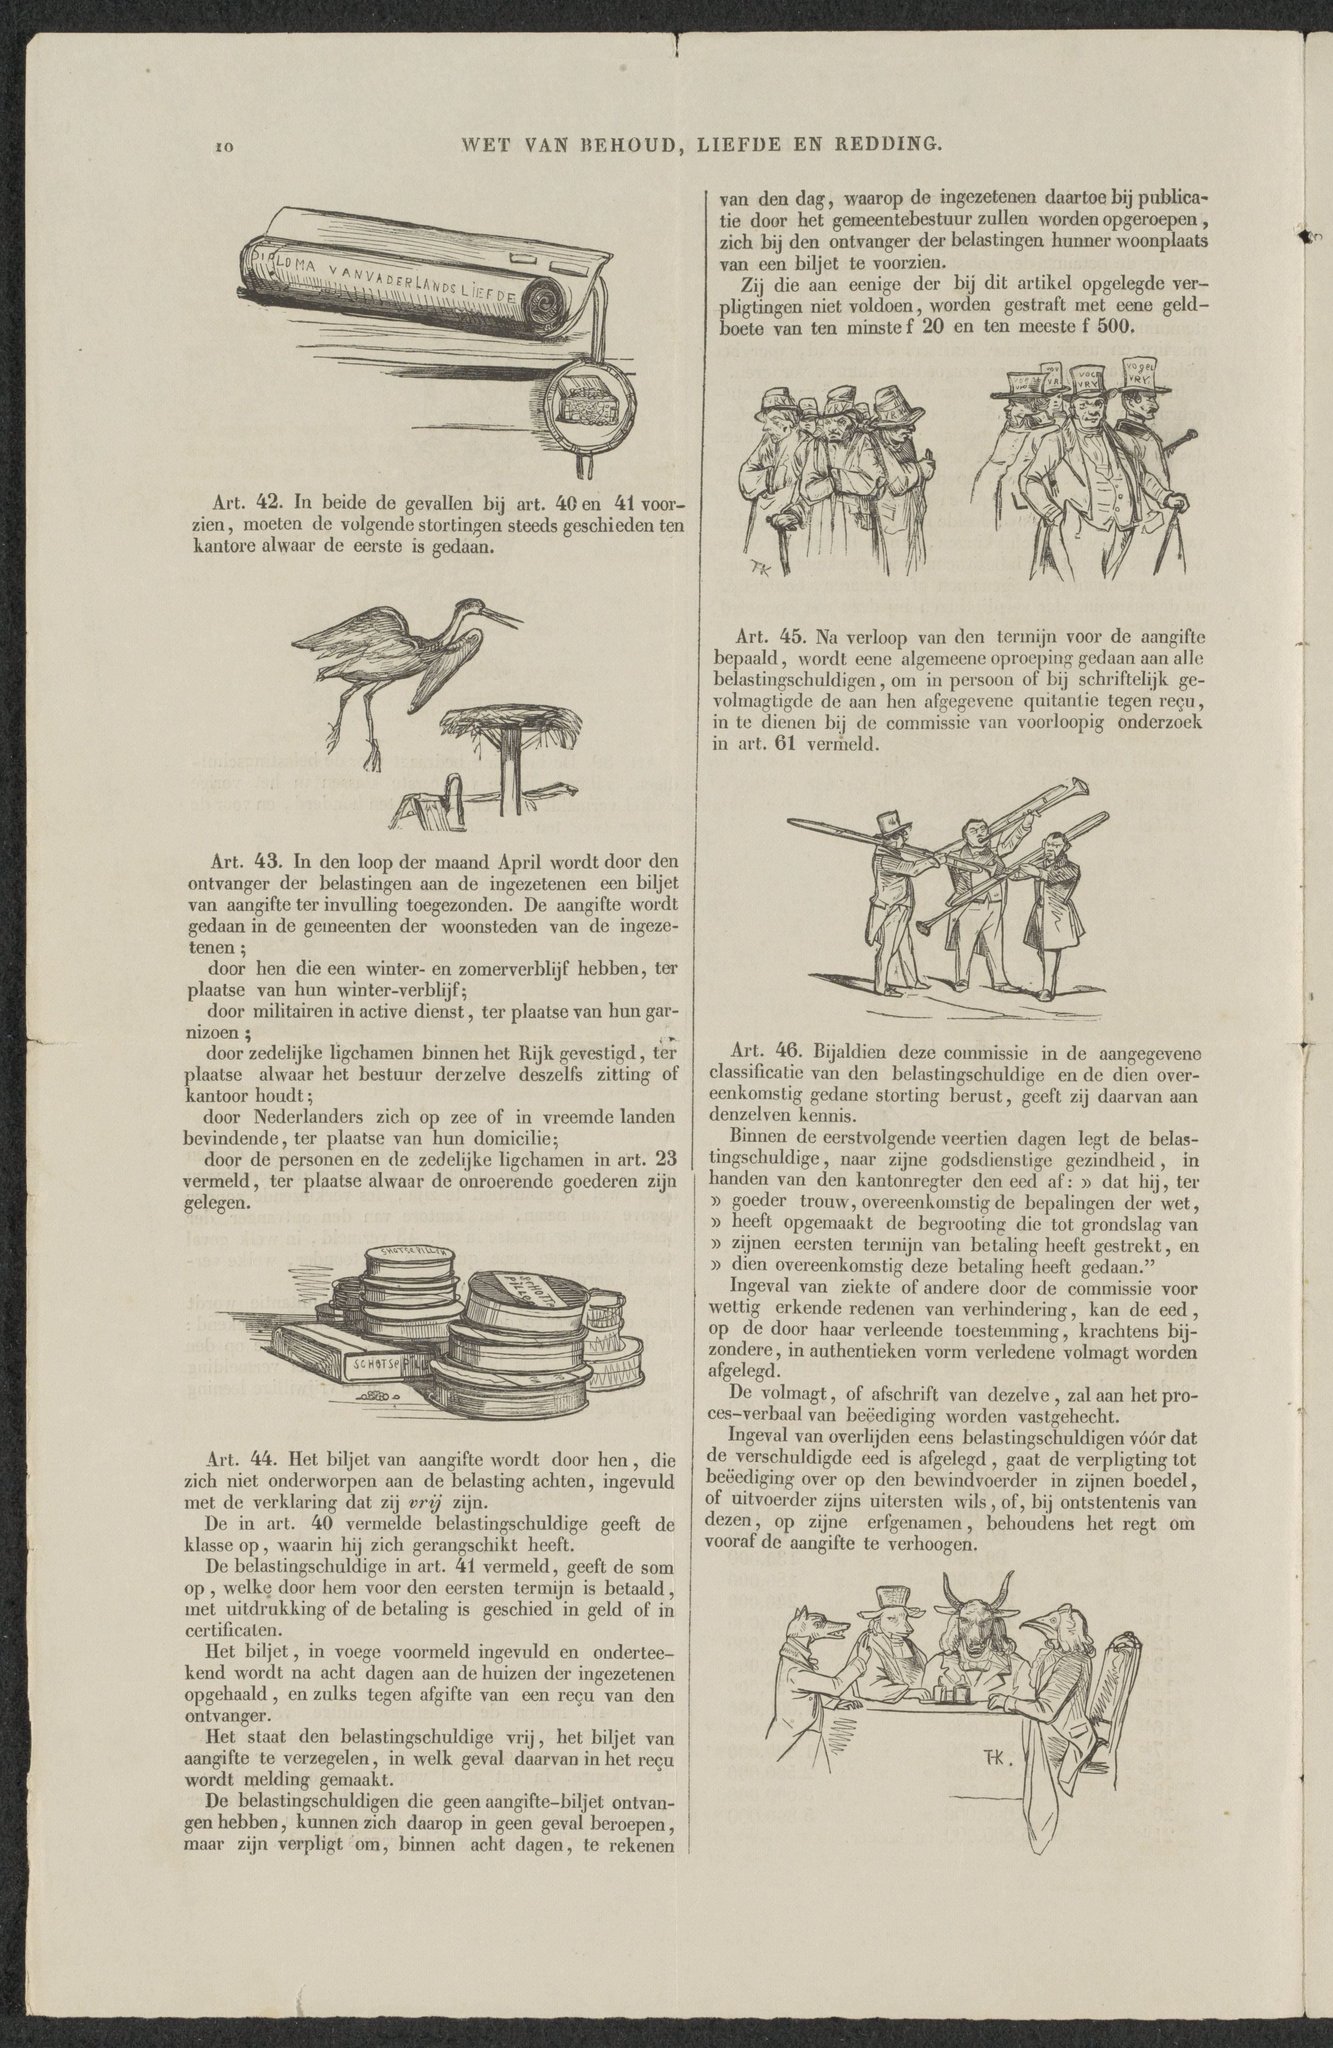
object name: print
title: Herdruk van de satire op de aansporing tot deelneming in de (zogenaamde) vrijwillige 3% geldlening van 1844 (blad 10)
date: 1844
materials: paper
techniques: letterpress printing, engraving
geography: the hague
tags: the hague, floris adriaan van hall, organization of trade and finance, taxes and financial administration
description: Bladzijde 10 met artikels 42-46 van het 'Vermeerderd, Verbeterd en de Volmaaktheid Overtreffend Nieuw Ontwerp van Wet van Behoud, Liefde en Redding'. Een enigszins aaangepaste herdruk van satire in zestien bladzijden op de aansporing tot deelneming in de (zogenaamde) vrijwillige 3% geldlening uitgeschreven in maart 1844 door minister F.A. van Hall. Binnenzijde van een dubbelgevouwen blad bedrukt op alle zijden.